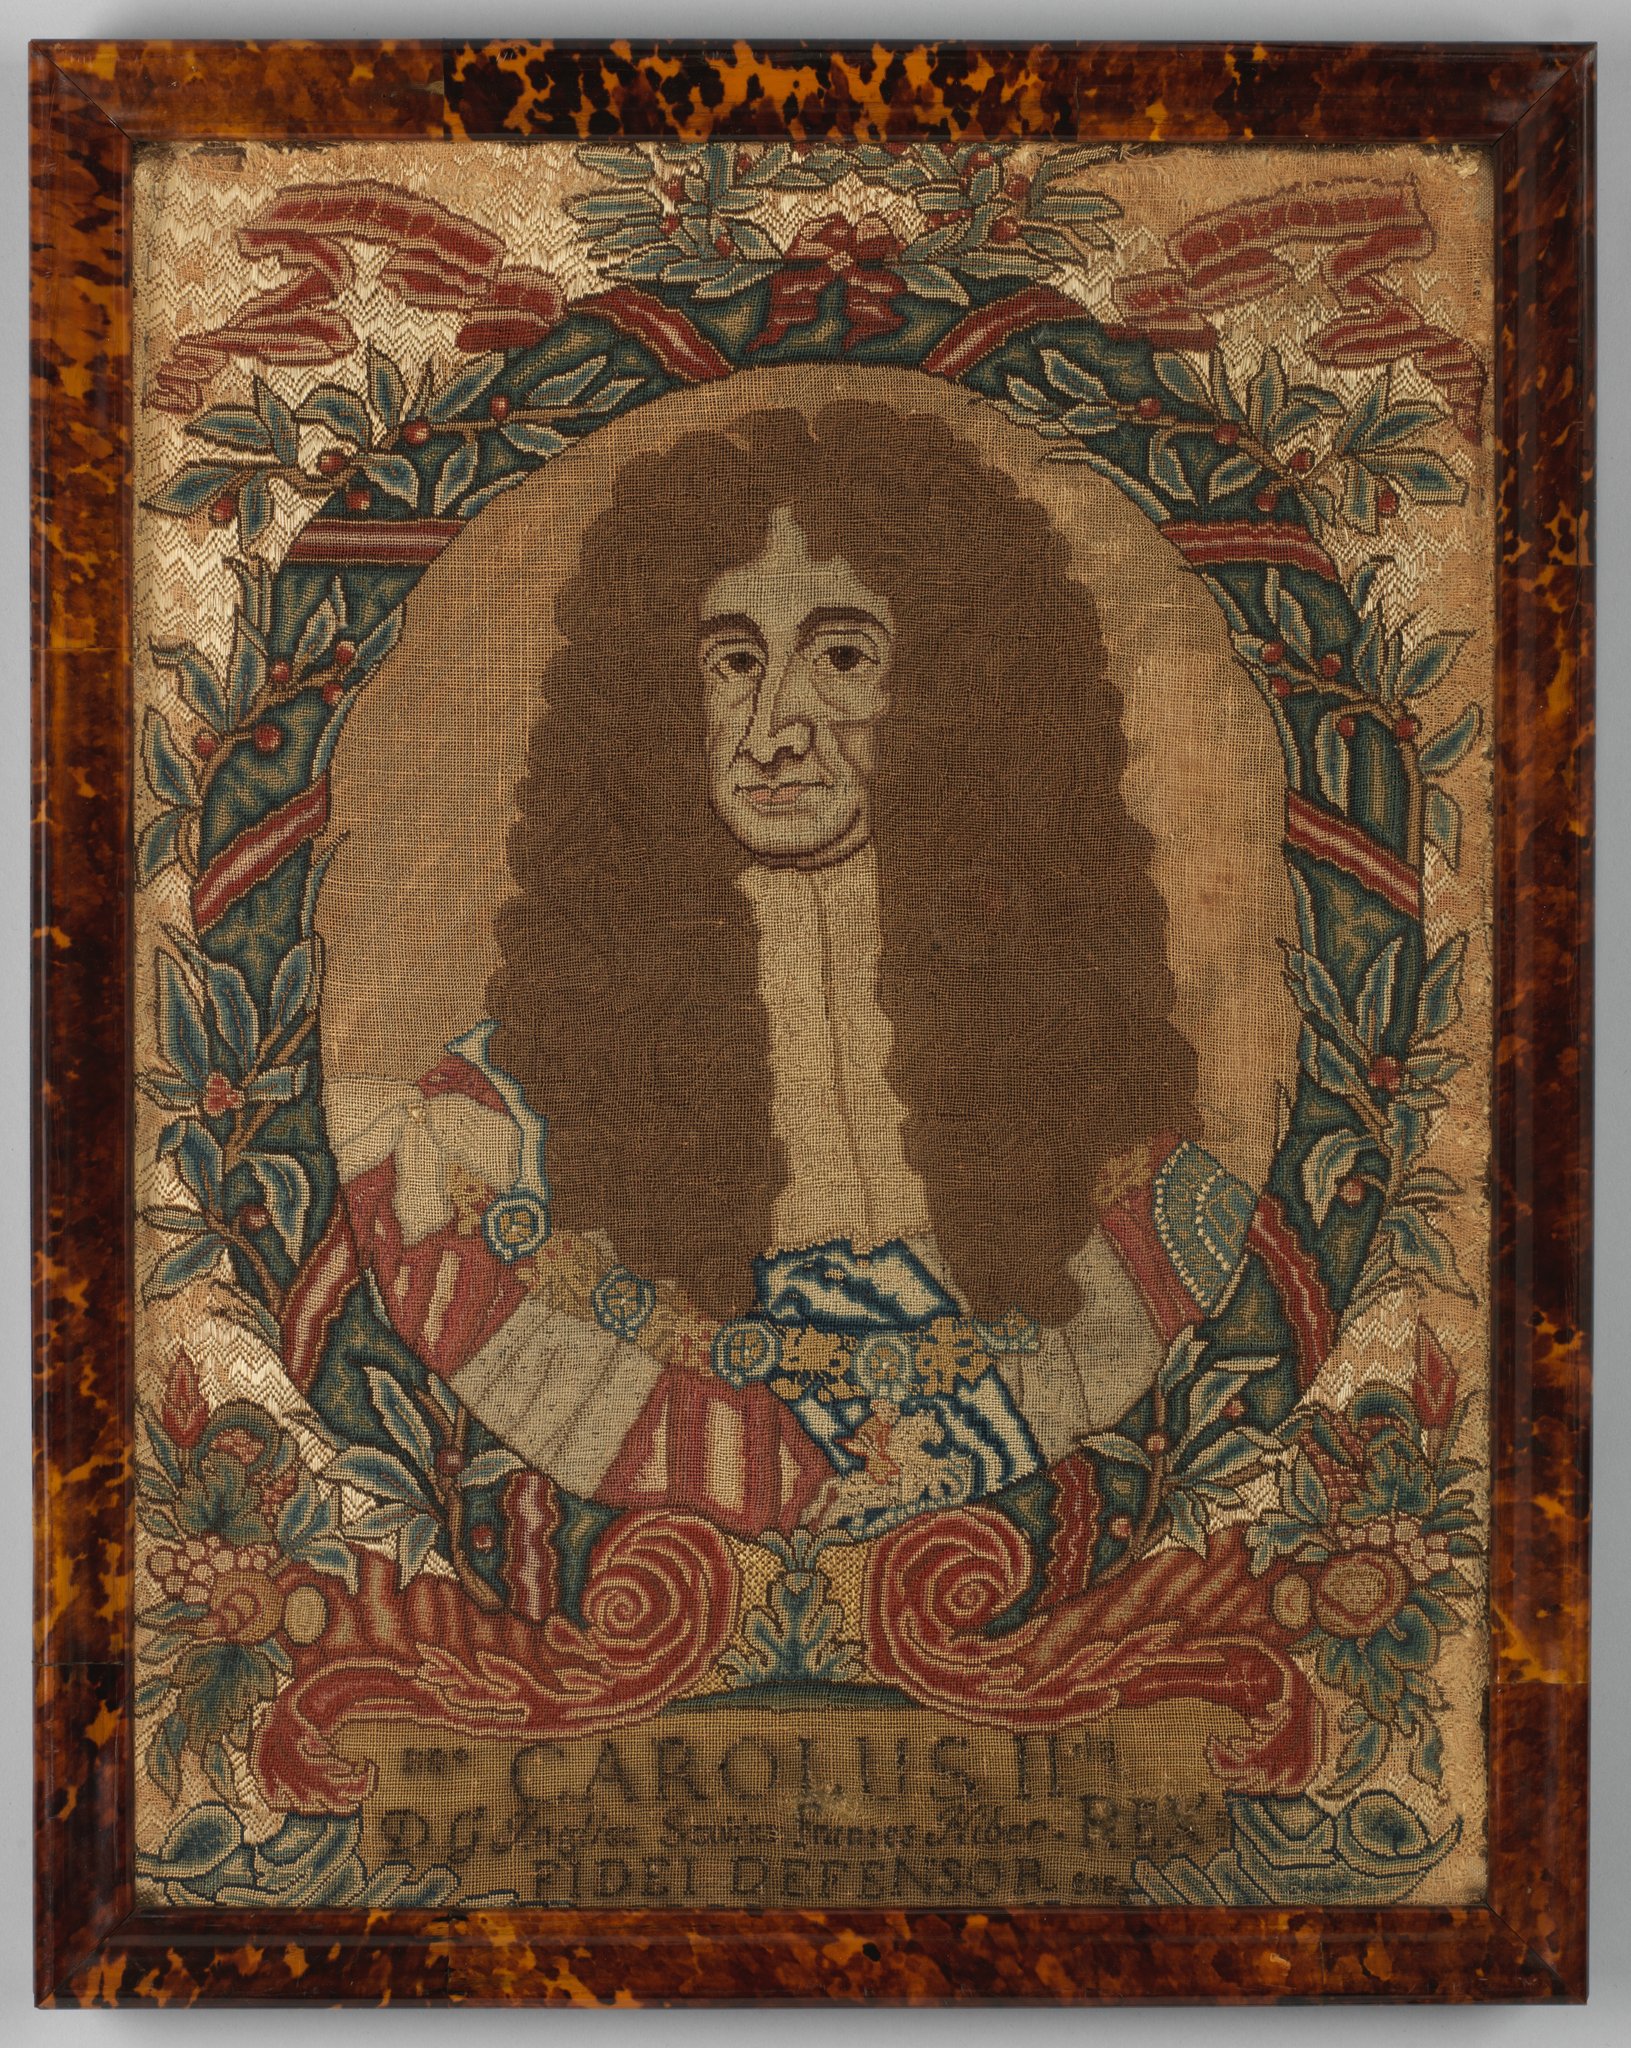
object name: portrait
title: Portrait of Charles II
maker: john baptist gaspars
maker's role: artist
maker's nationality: flemish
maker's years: 1615-1691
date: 1667-1733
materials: canvas, silk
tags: kings,men,portraits